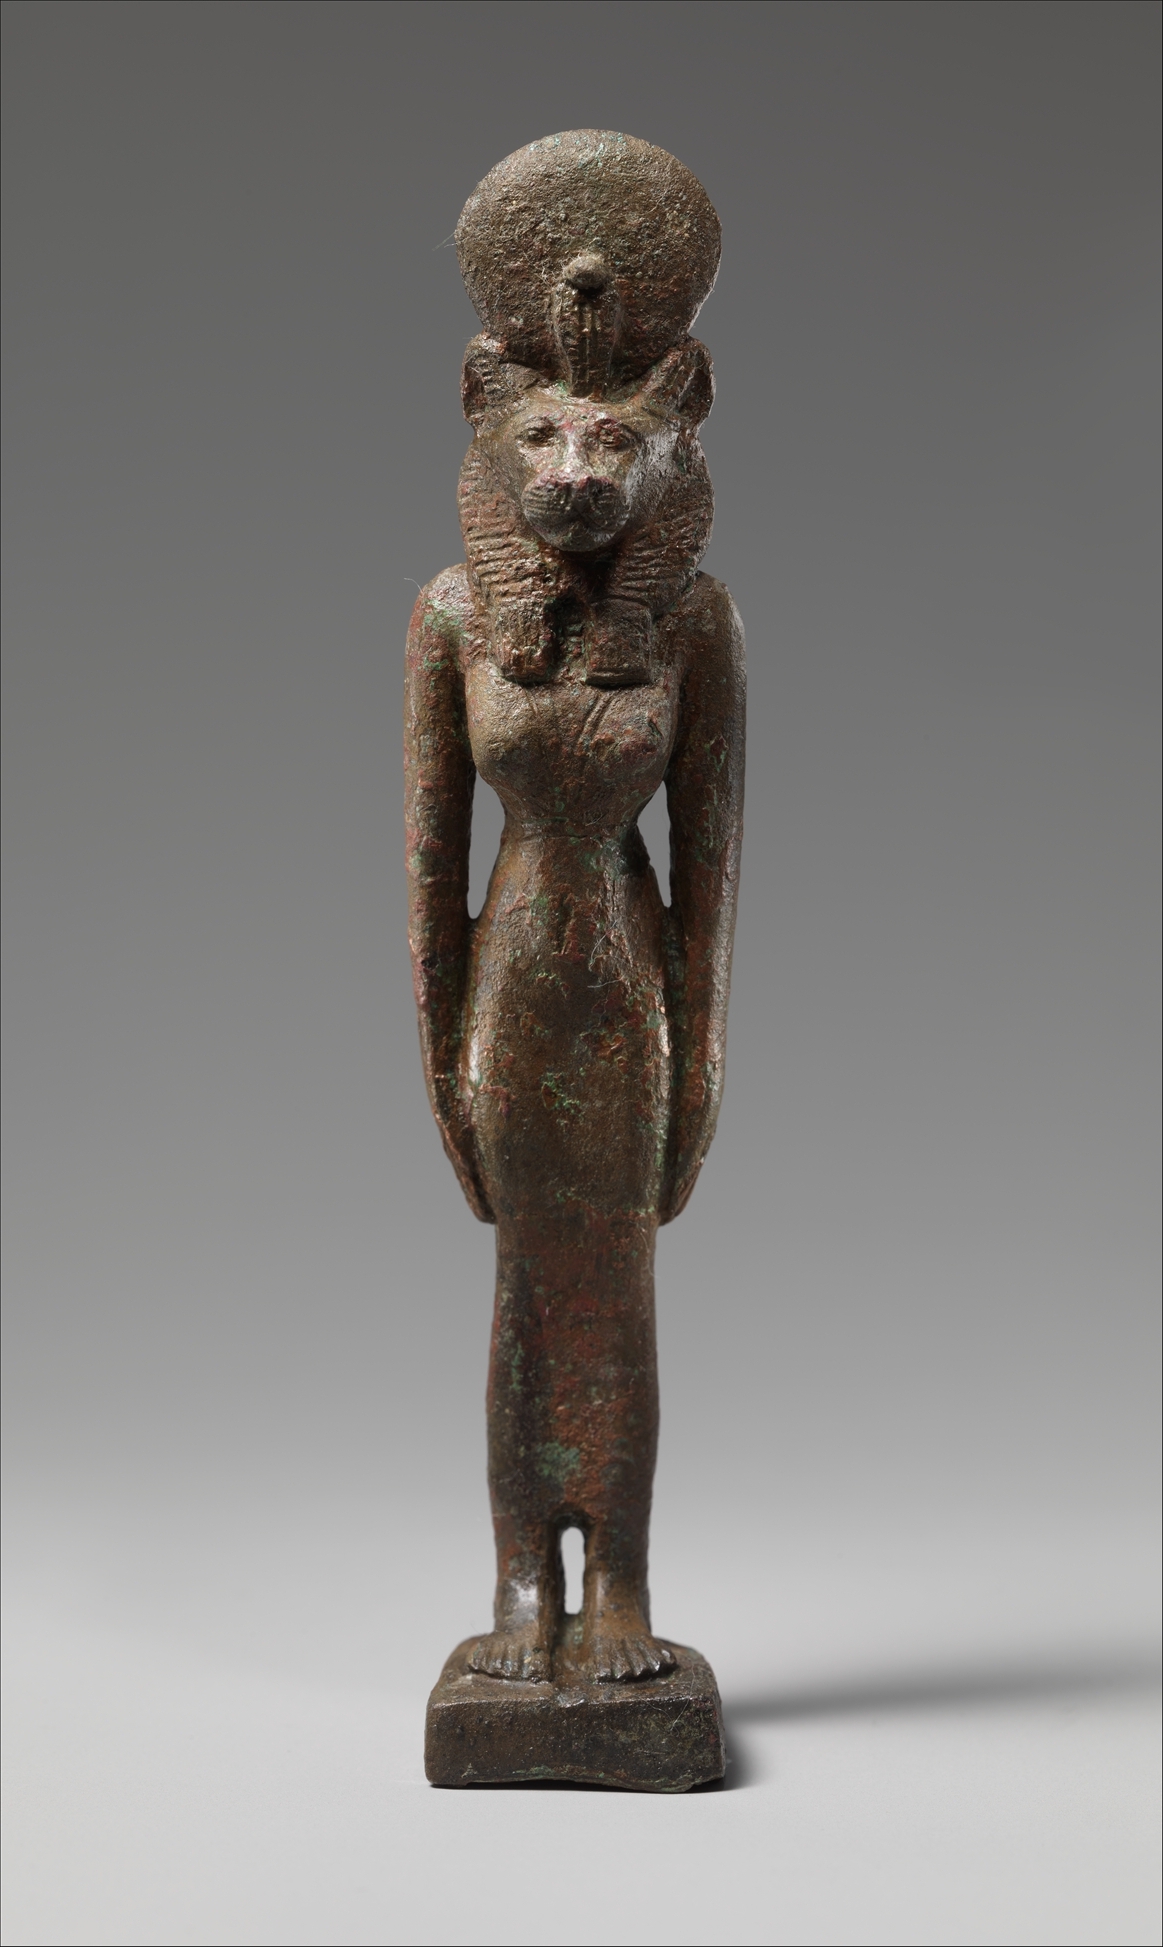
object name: statuette, lion headed goddess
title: Lion-Headed Goddess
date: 664-630 BCE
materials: metal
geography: egypt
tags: sekhmet